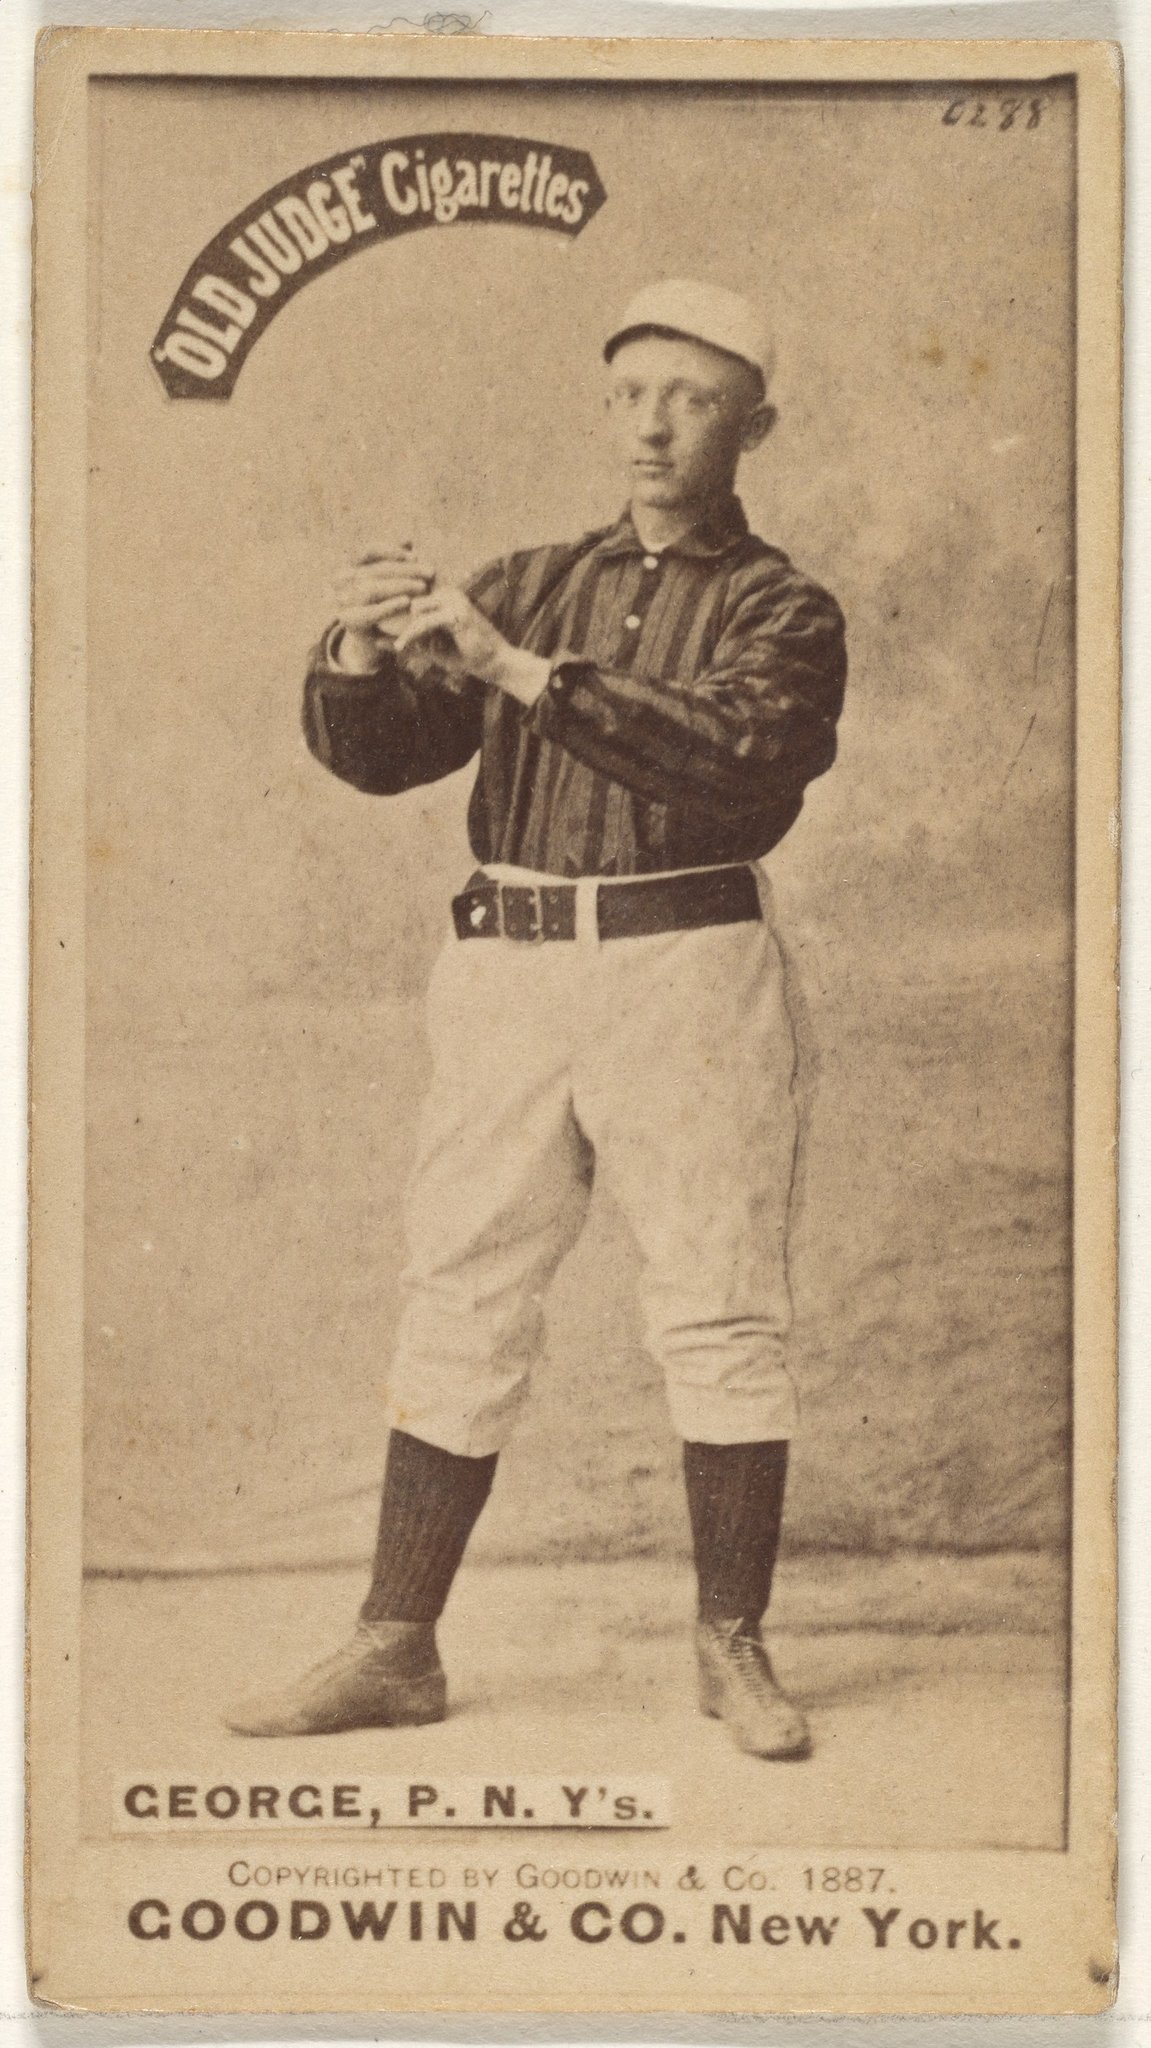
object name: baseball card, photograph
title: Bill George, Pitcher, New York, from the Old Judge series (N172) for Old Judge Cigarettes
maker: goodwin & company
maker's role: publisher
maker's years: 1850-1950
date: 1887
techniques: albumen silver print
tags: men,portraits,baseball,athletes